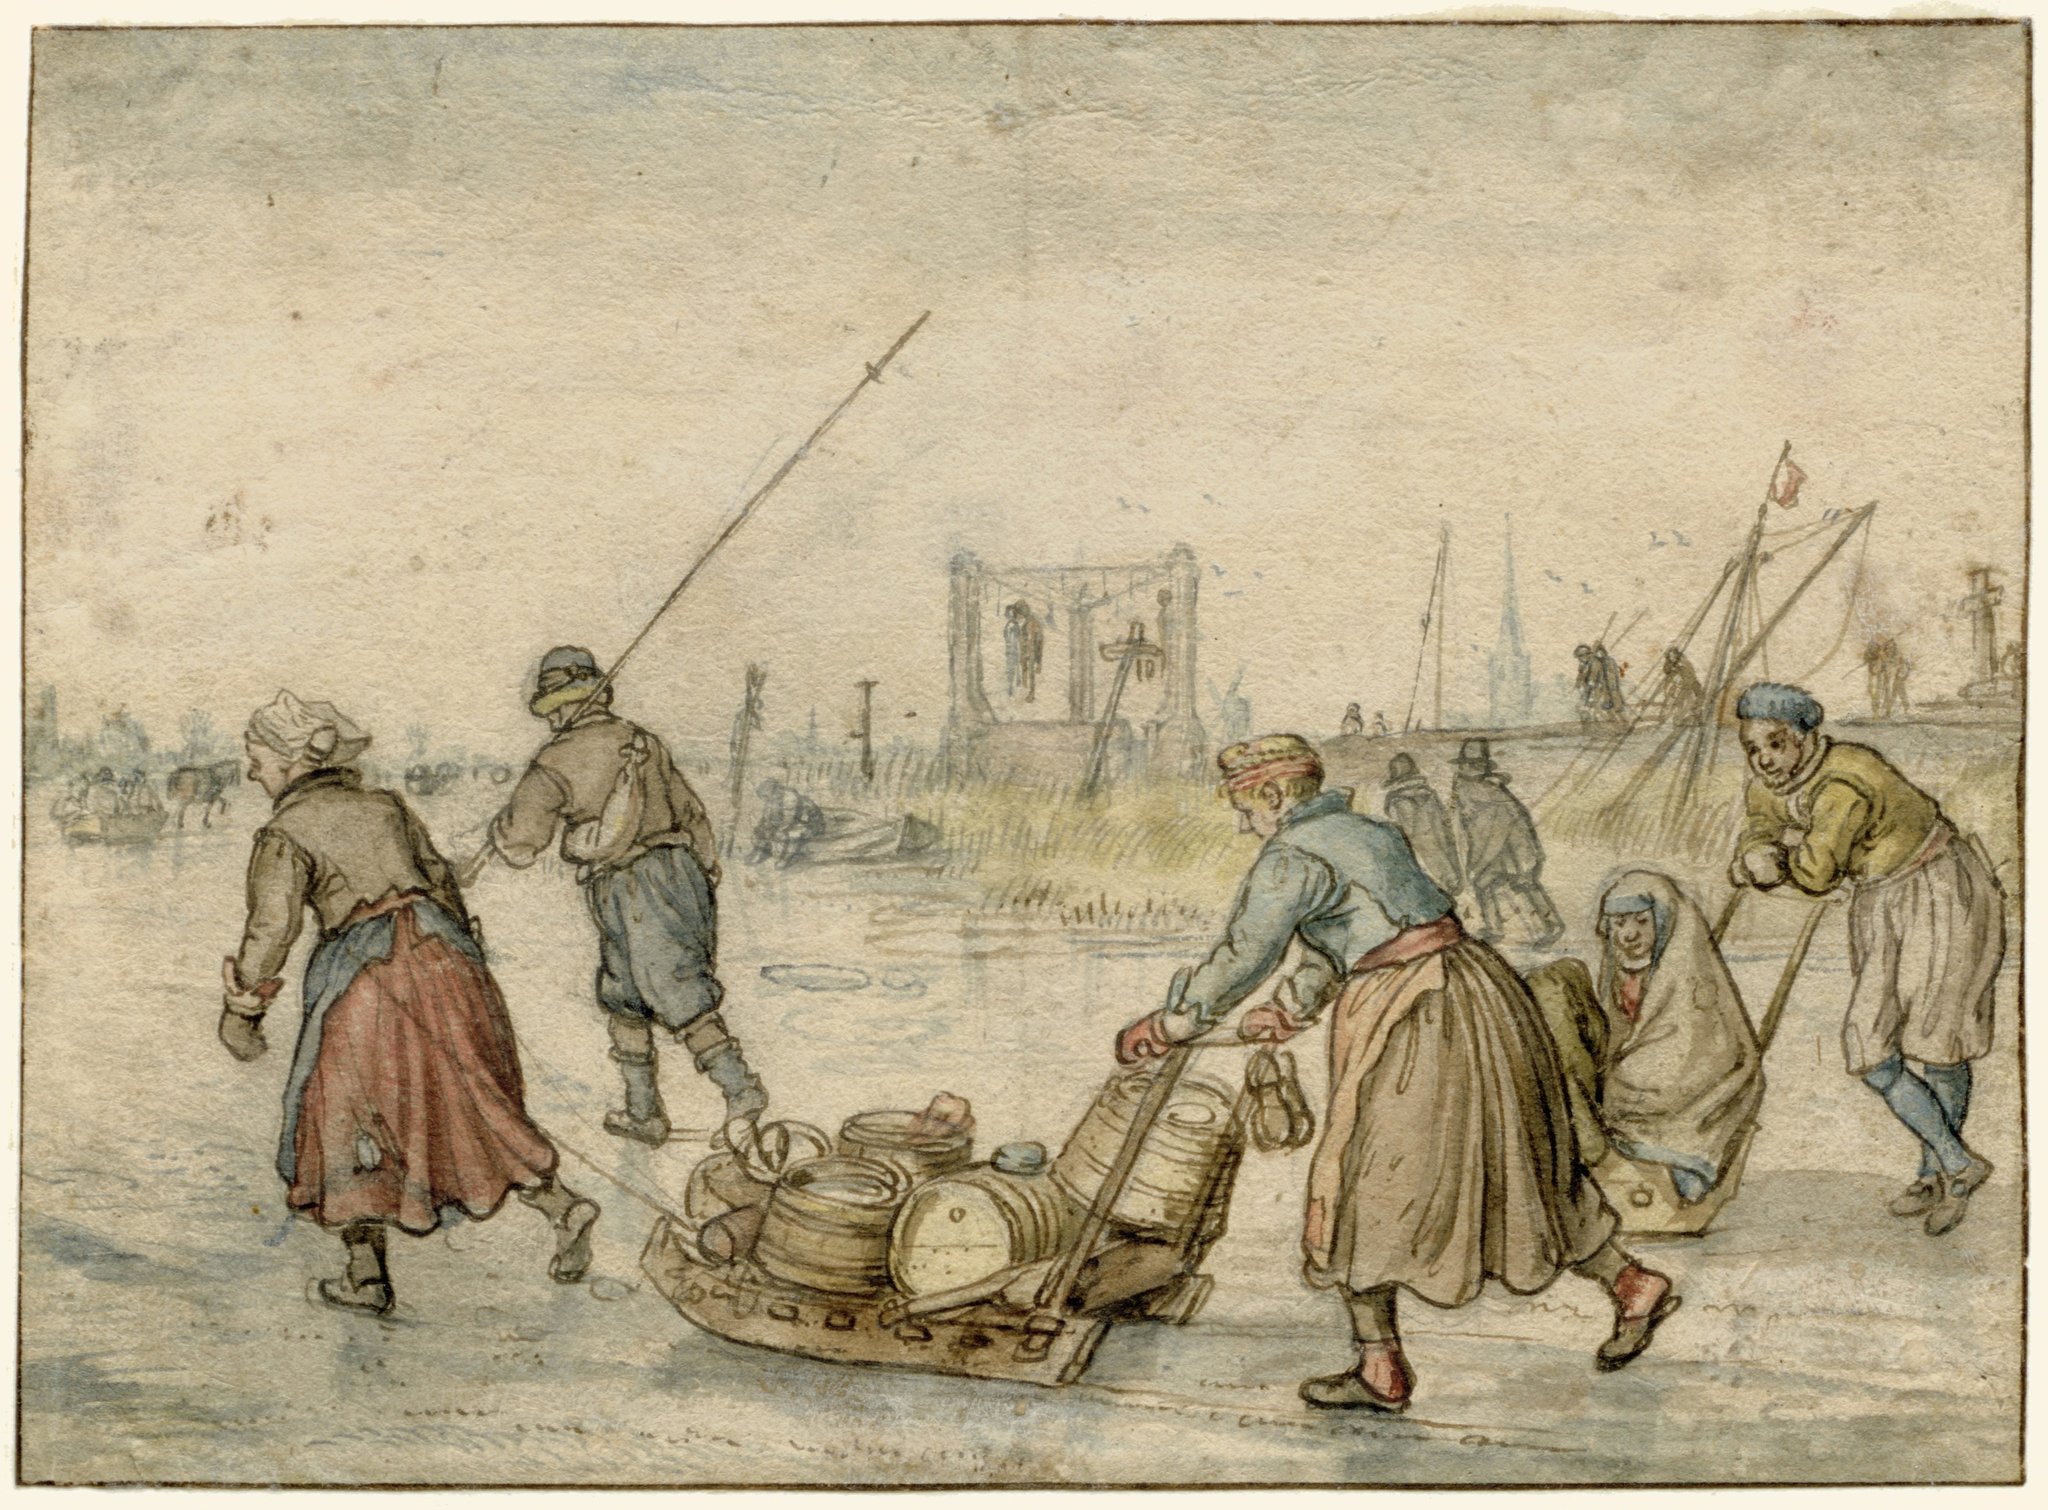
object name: drawing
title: Winter Landscape with Two Women and a Sledge and Other Figures on the Ice, a Gallows in the Distance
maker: hendrick avercamp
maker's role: draughtsman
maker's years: 1585-1634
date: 1620-1625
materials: chalk, graphite, ink, paper, watercolor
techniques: brush, pen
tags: instruments of torture, execution or punishment: gallows, sleigh, sledge (non-sport), sledge, sleigh (winter sports)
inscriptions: title: ‘Het IJ by Winter/op het 2de plan de Volewyk’, date: ‘1620’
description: Twee vrouwen met een slede en andere figuren op het ijs; in de verte een galg.